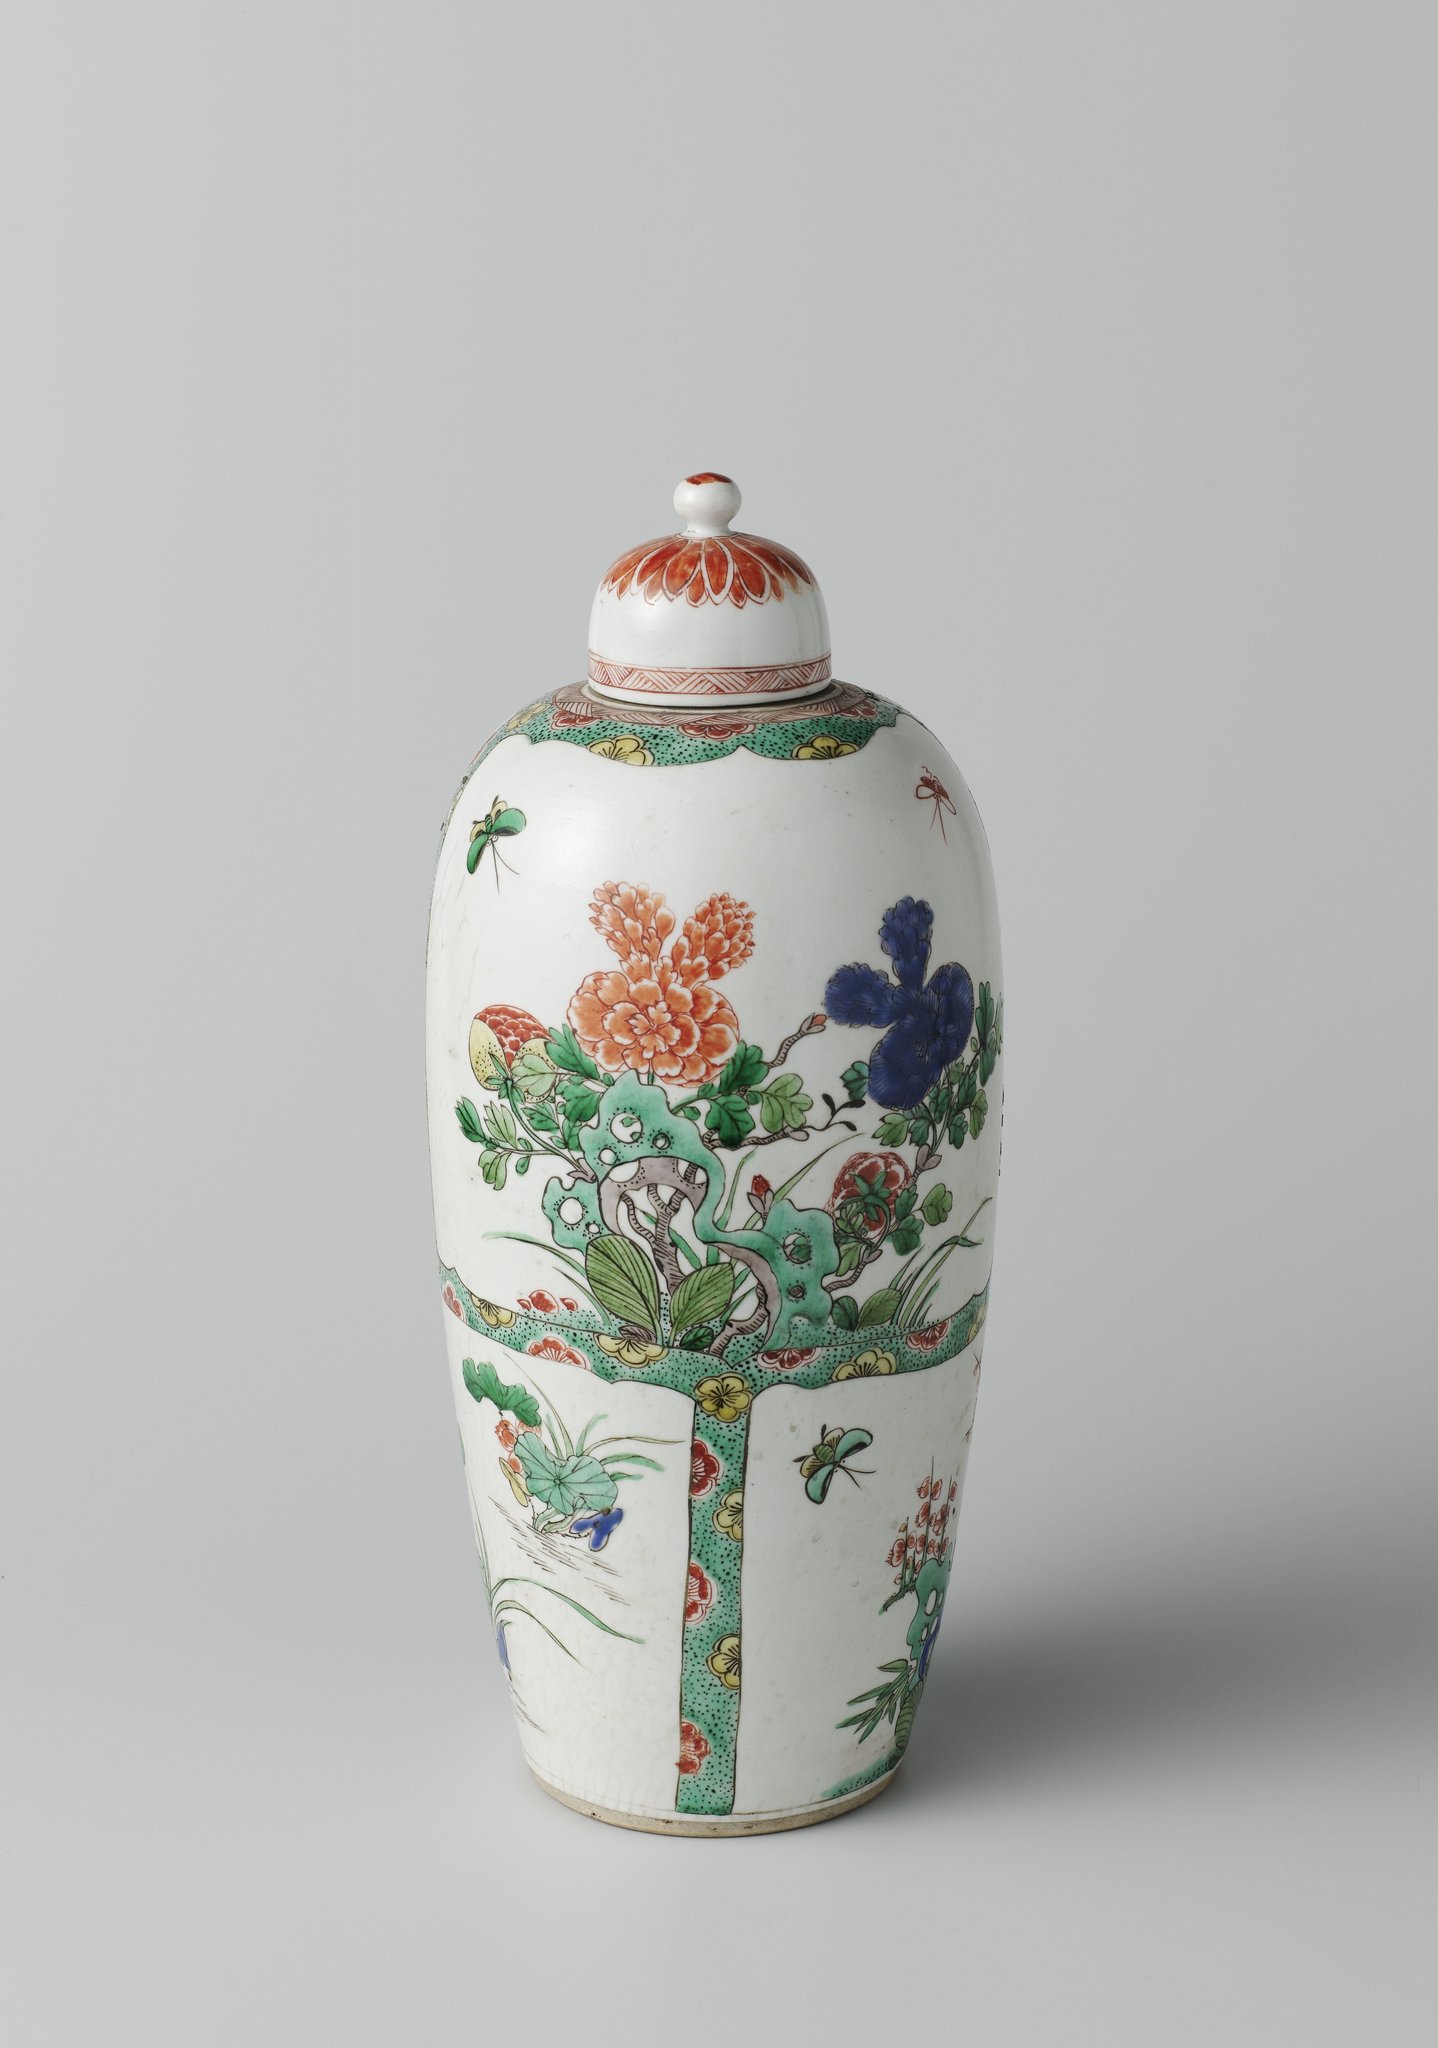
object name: covered jar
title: Ovoid covered jar with flowering plants in panels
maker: Anonymous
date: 1700-1724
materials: glaze, paint, porcelain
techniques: firing, turning, vitrification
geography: china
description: AK-NM-6456 Twee dekselpotten • Famille verte porselein • Onderdeel van Royers porseleinverzameling • Gepubliceerd: Jörg 2011, nr. 116 Deze dekselpotten zijn op het eerste gezicht ‘normale’ stukken famille verte, maar bij nadere bestudering is een aantal elementen afwijkend [Jörg 2011]: ze zijn opvallend zwaar, ze zijn erg hoog, de glazuur is opmerkelijk dun, het wit van de scherf is tamelijk grijs, de kleuren zijn erg hard. Het Rijksmuseum heeft een verwant paar (AK-RBK-16346, hoogte 20,5 cm), dat er wel uitziet zoals wij van een stuk famille verte uit de Kangxi-periode verwachten. De vorm is iets minder gerekt, het glazuur is normaal en er is een decoratieve band geschilderd rond de voet. Bovendien hebben ze een normale, gladde dop, zonder het opmerkelijke knopje en de opmerkelijke beschildering. Dat geldt ook voor een paar in het National History Museum in Taipei [Bulletin Taipei 2001, achterzijde (h. 32,5)]. Vooralsnog is het niet duidelijk waarom dit stuk zo afwijkt van wat wij zien als ‘de norm’ voor famille verte. Technisch onderzoek kan hopelijk voor meer duidelijkheid zorgen. Het is mogelijk dat de potten níet van Royer waren, maar later aan de collectie zijn toegevoegd. Dit zou dan gebeurd moeten zijn vóór 1876, toen het paar genummerd werd en ingeschreven. Het zouden 19de-eeuwse navolgingen van Kangxi-porselein kunnen zijn. Bronnen Bulletin of the National Museum of History XI/4 (2001). Christiaan J.A. Jörg, Famille verte: Chinese porcelain in green enamels, Groningen, 2011.